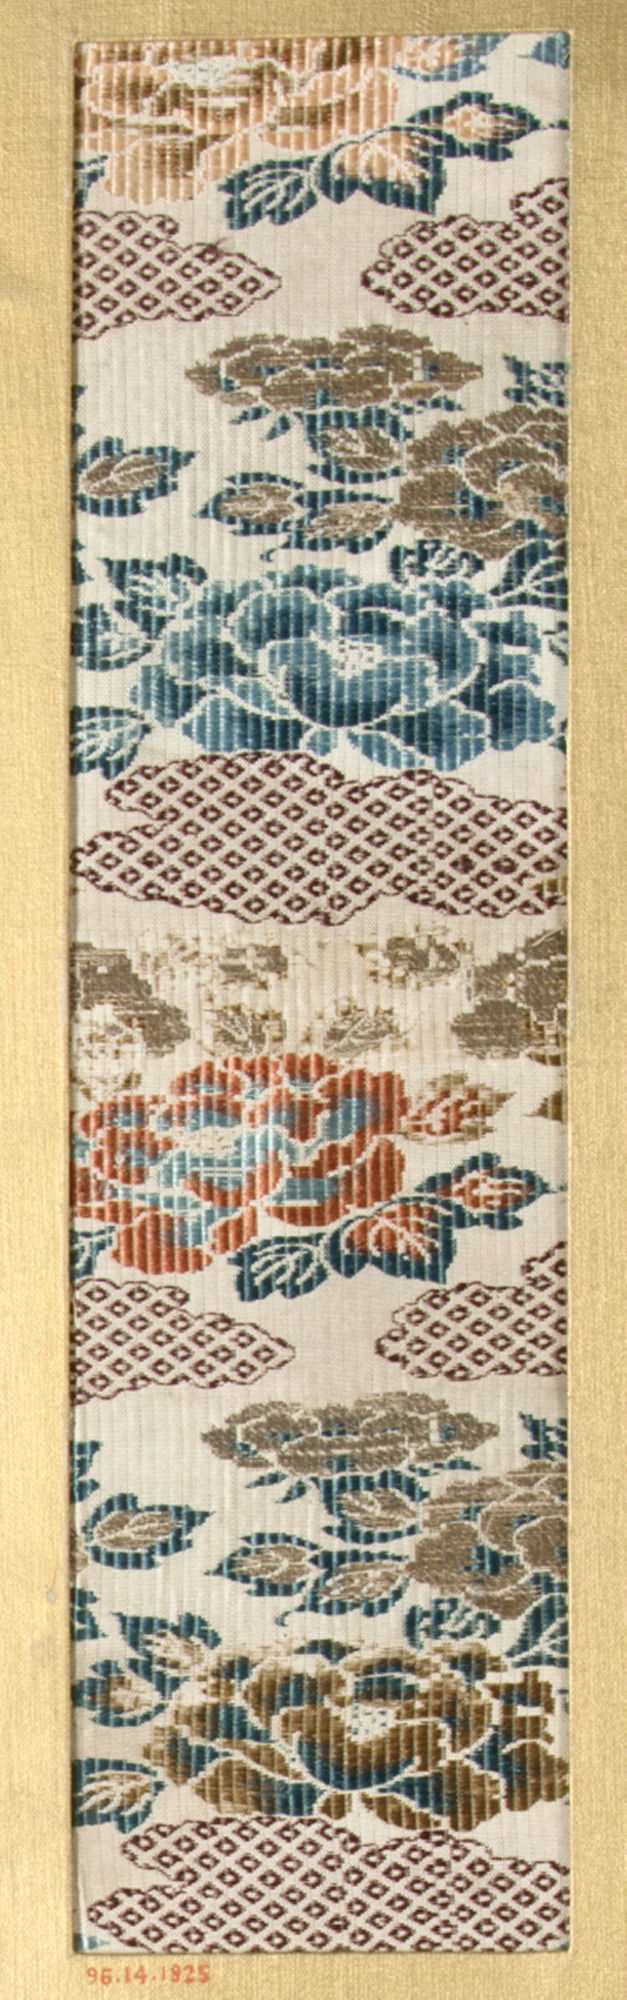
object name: piece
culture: japanese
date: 1701-1900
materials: silk